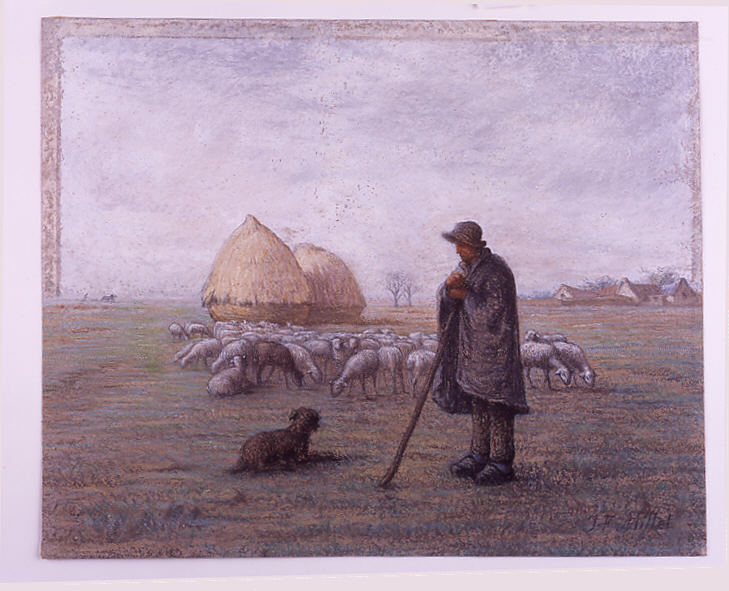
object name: drawing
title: Shepherd and His Flock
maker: jean-françois millet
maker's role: artist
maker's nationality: french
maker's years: 1814-1875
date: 1867-1900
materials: paper, pastel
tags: men,dogs,sheep,shepherds